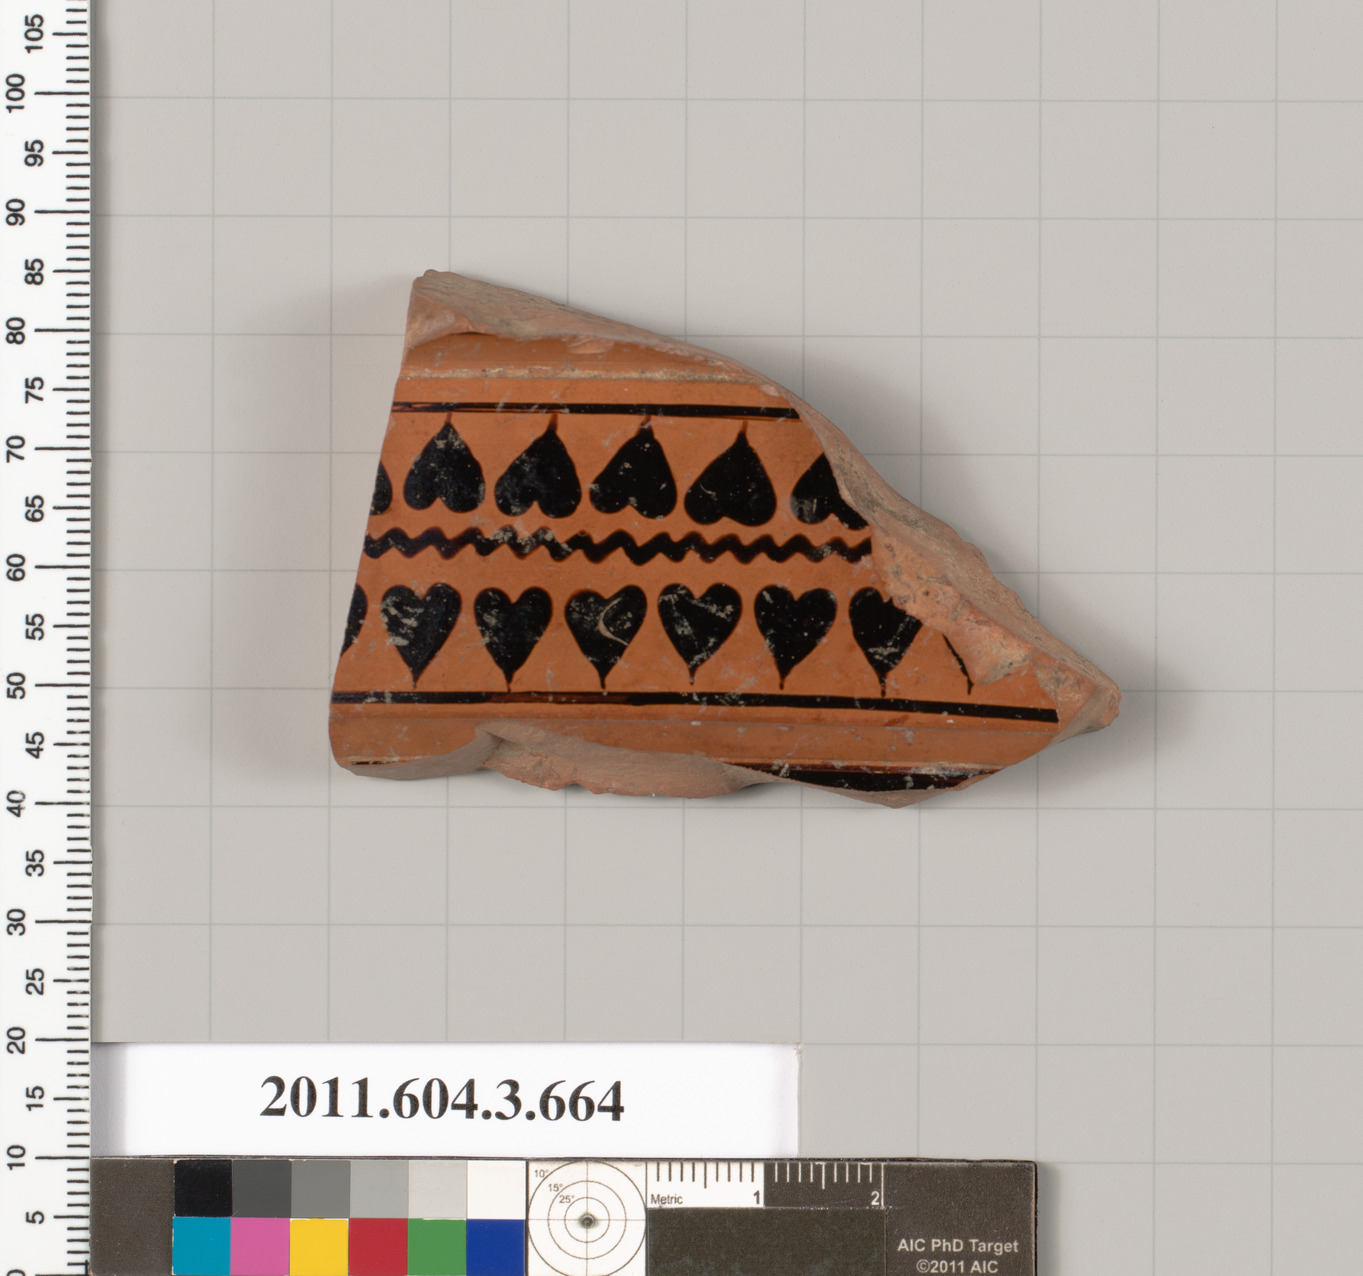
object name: calyx krater fragment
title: Terracotta fragment of a calyx-krater (bowl for mixing wine and water)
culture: greek, attic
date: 550-501 BCE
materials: terracotta